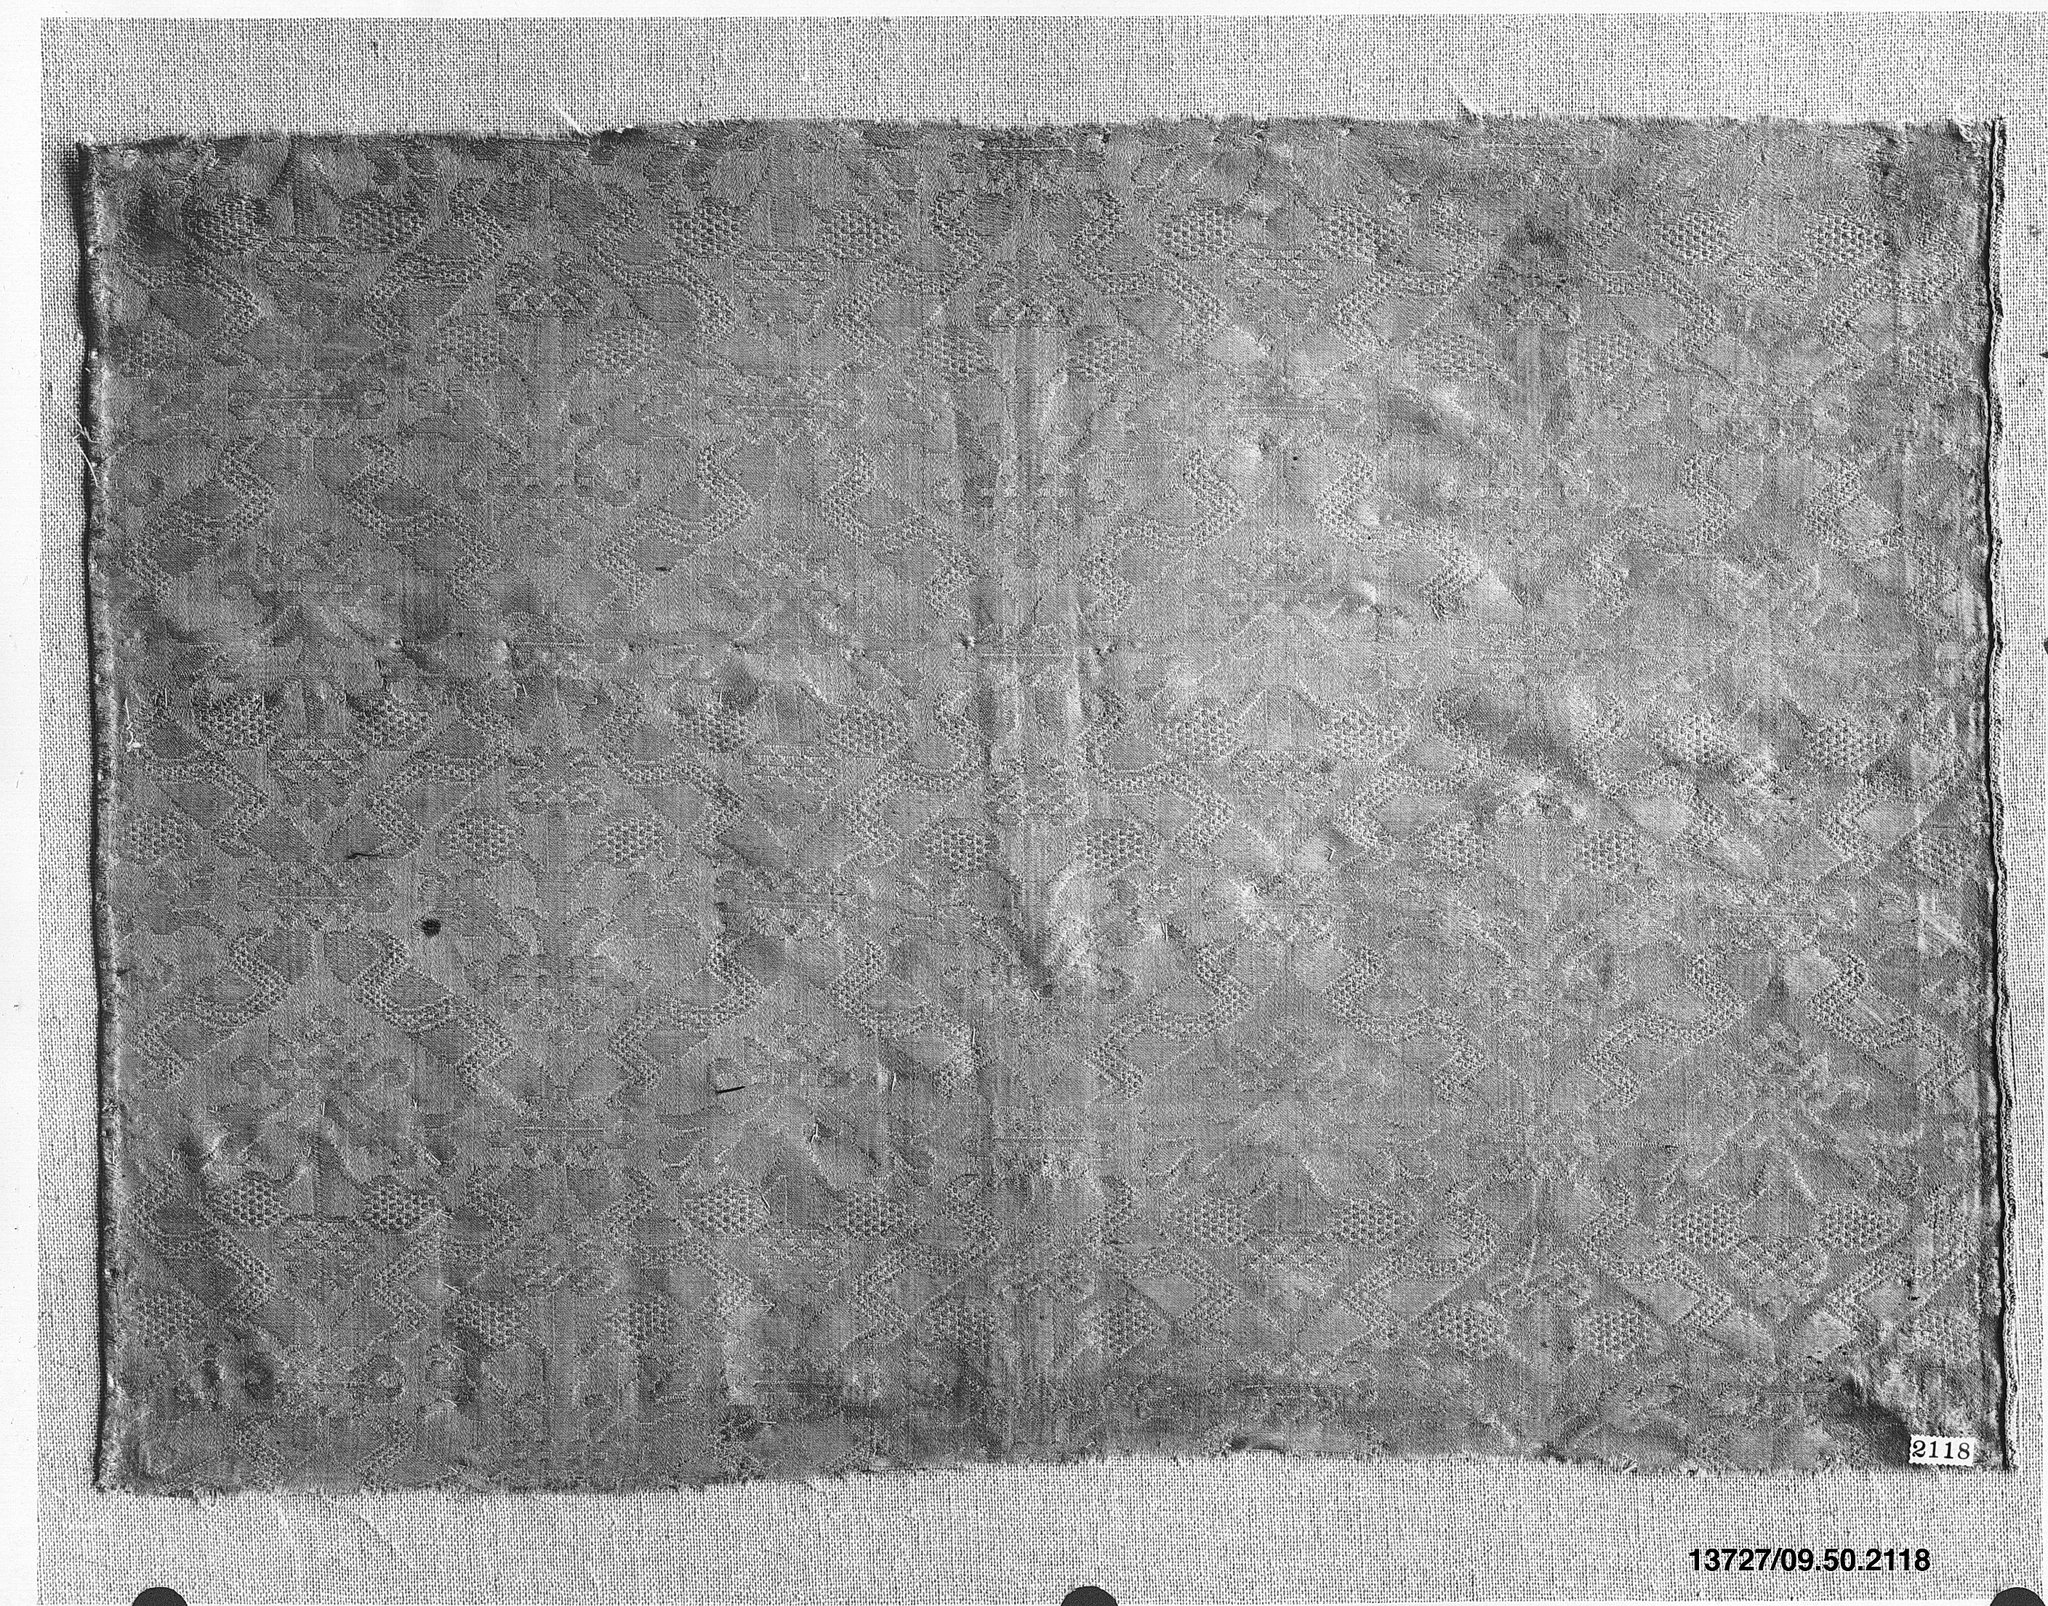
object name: piece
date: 1501-1600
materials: silk